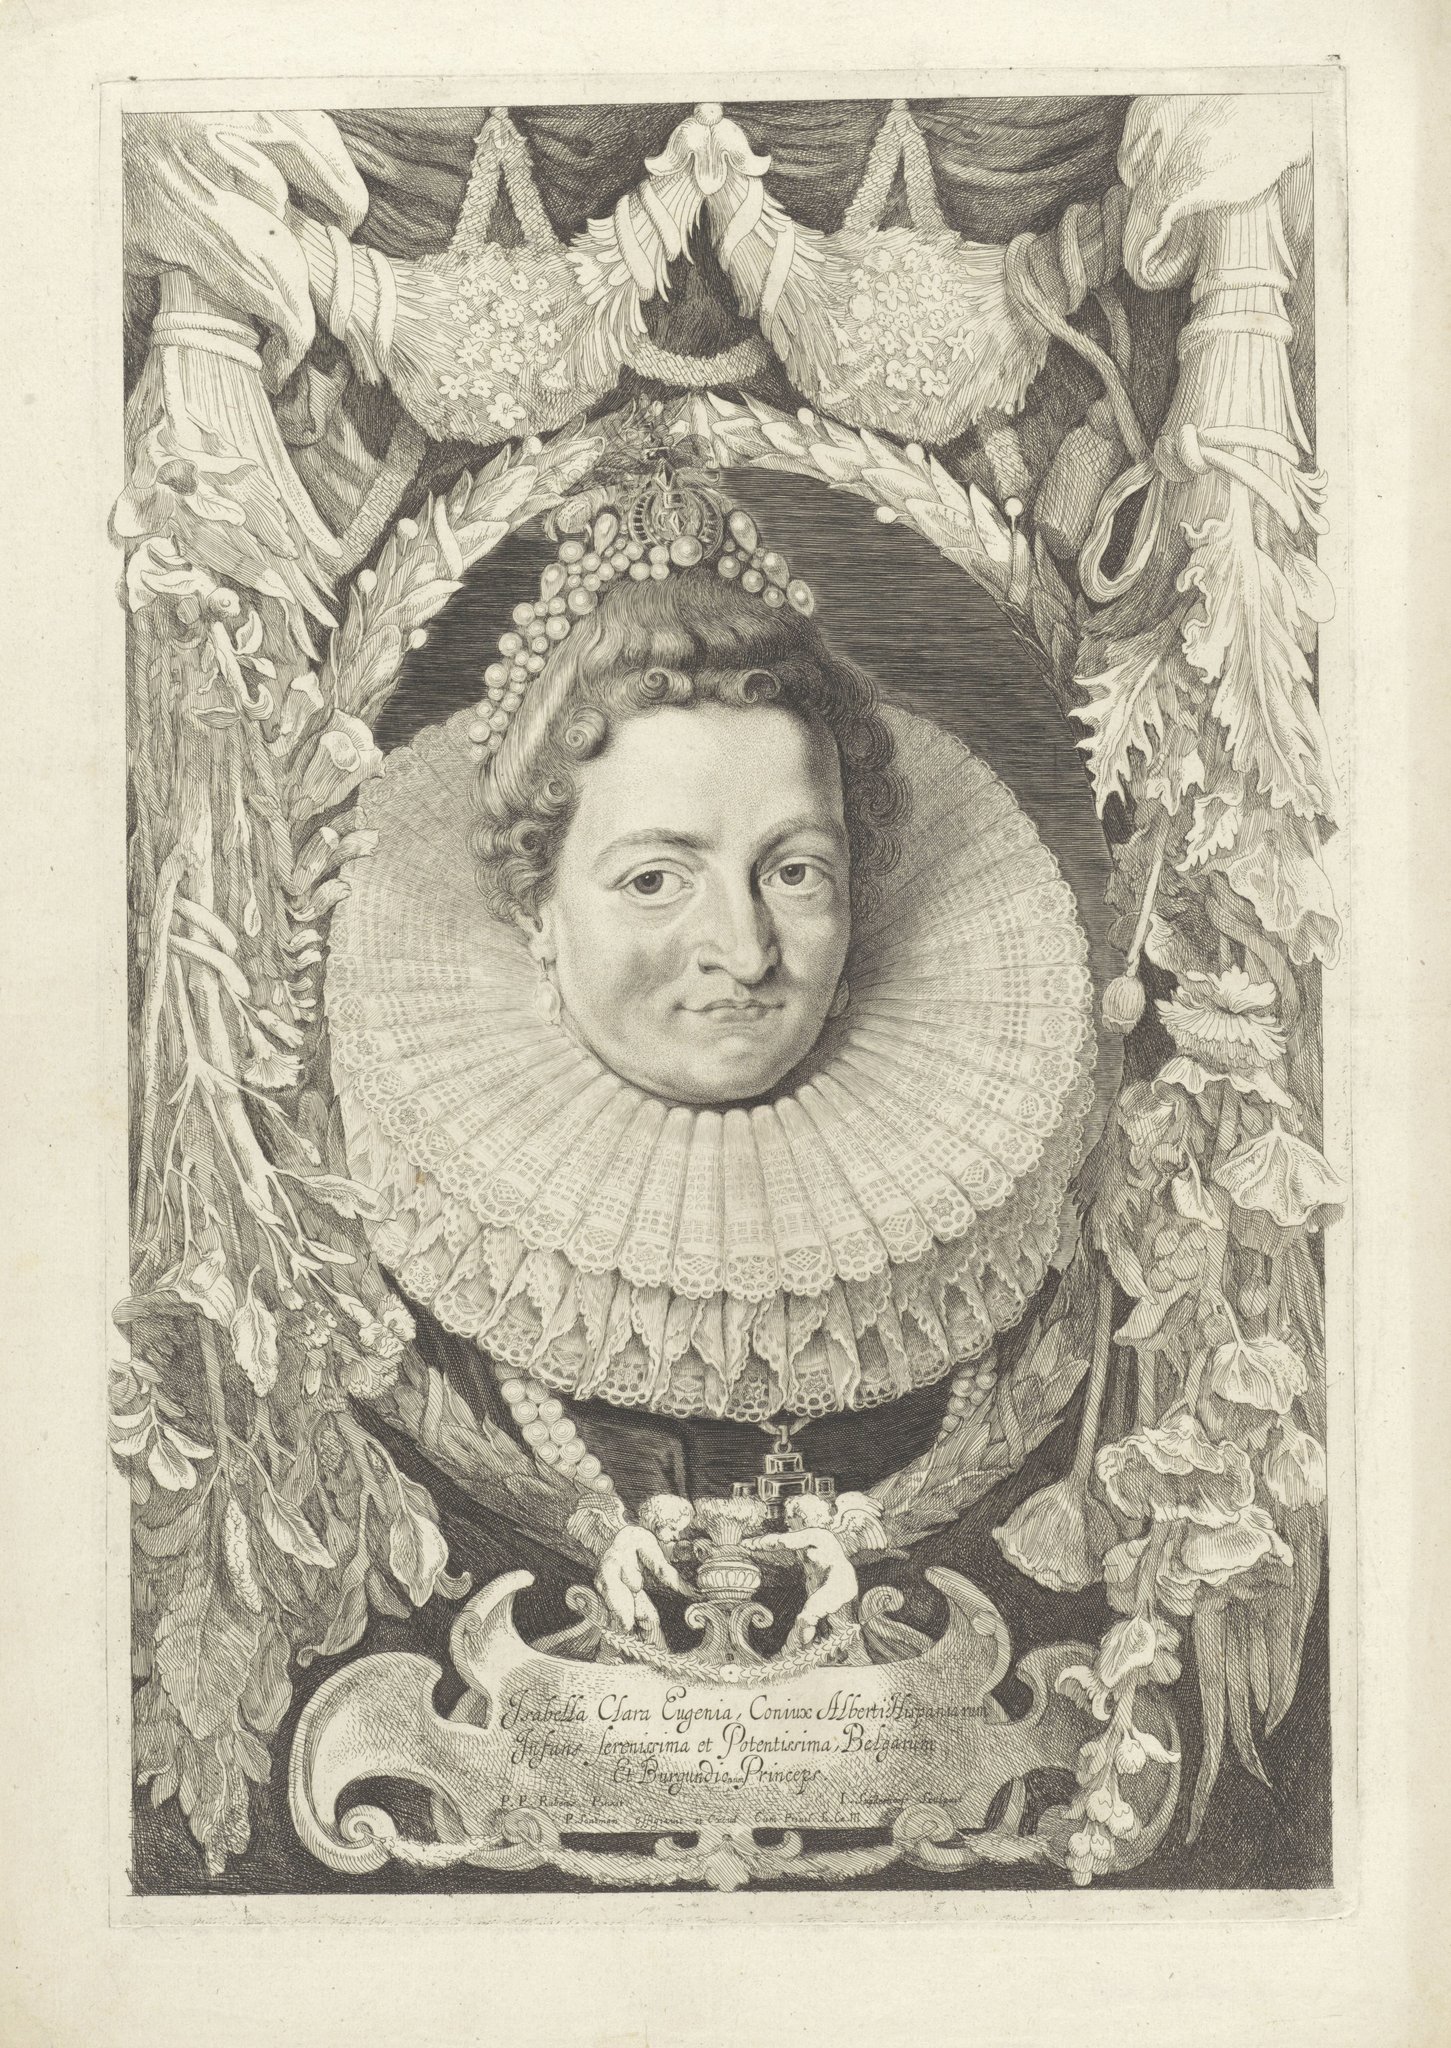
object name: print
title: Ferdinandus II[us] et III[us] Imperatorum Domus Austriacae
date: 1644-1650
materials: paper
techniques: engraving, etching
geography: haarlem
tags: infante van spanje isabella clara eugenia, ornament ~ festoon, garland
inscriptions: collector's mark: Lugt 2233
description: Portret van Isabella Clara Eugenia, infante van Spanje. Het portret is gevat in een ornamentele omlijsting met guirlandes van bladeren en bloemen. Midden onder een cartouche met haar naam en titel in het Latijn.